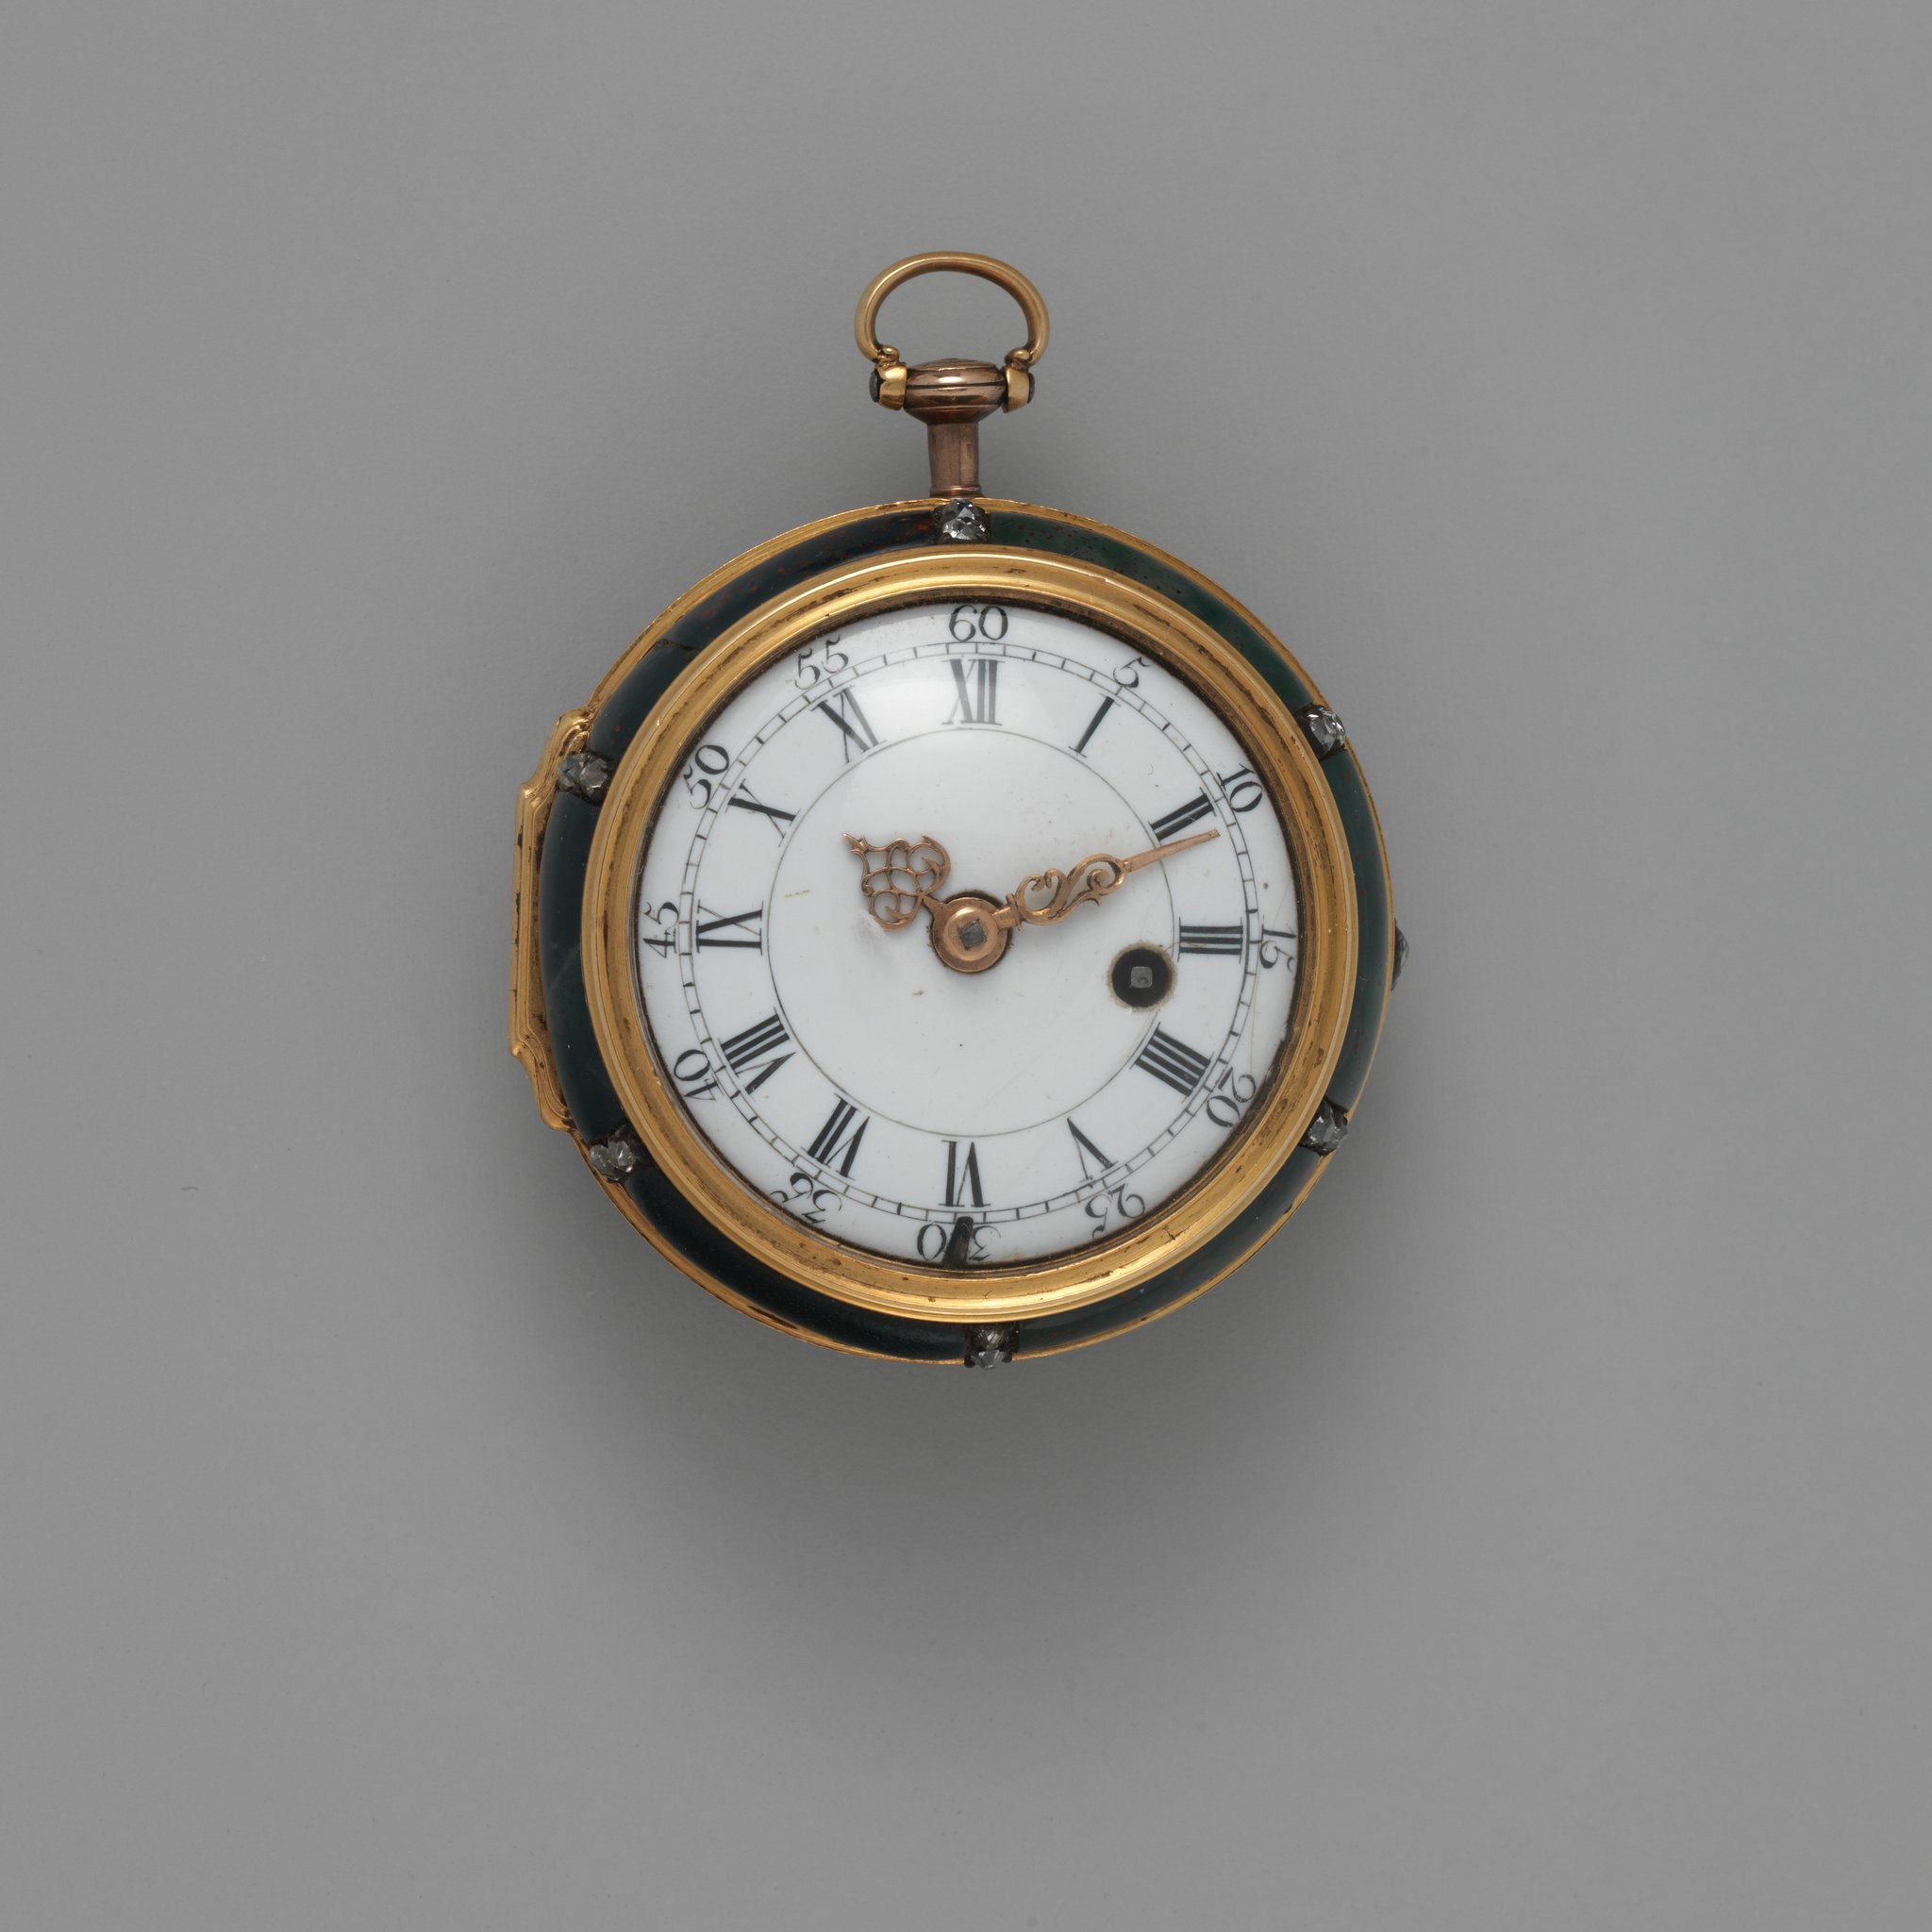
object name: watch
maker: george dutens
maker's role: maker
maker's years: 1735-1765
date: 1740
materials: diamond, gold